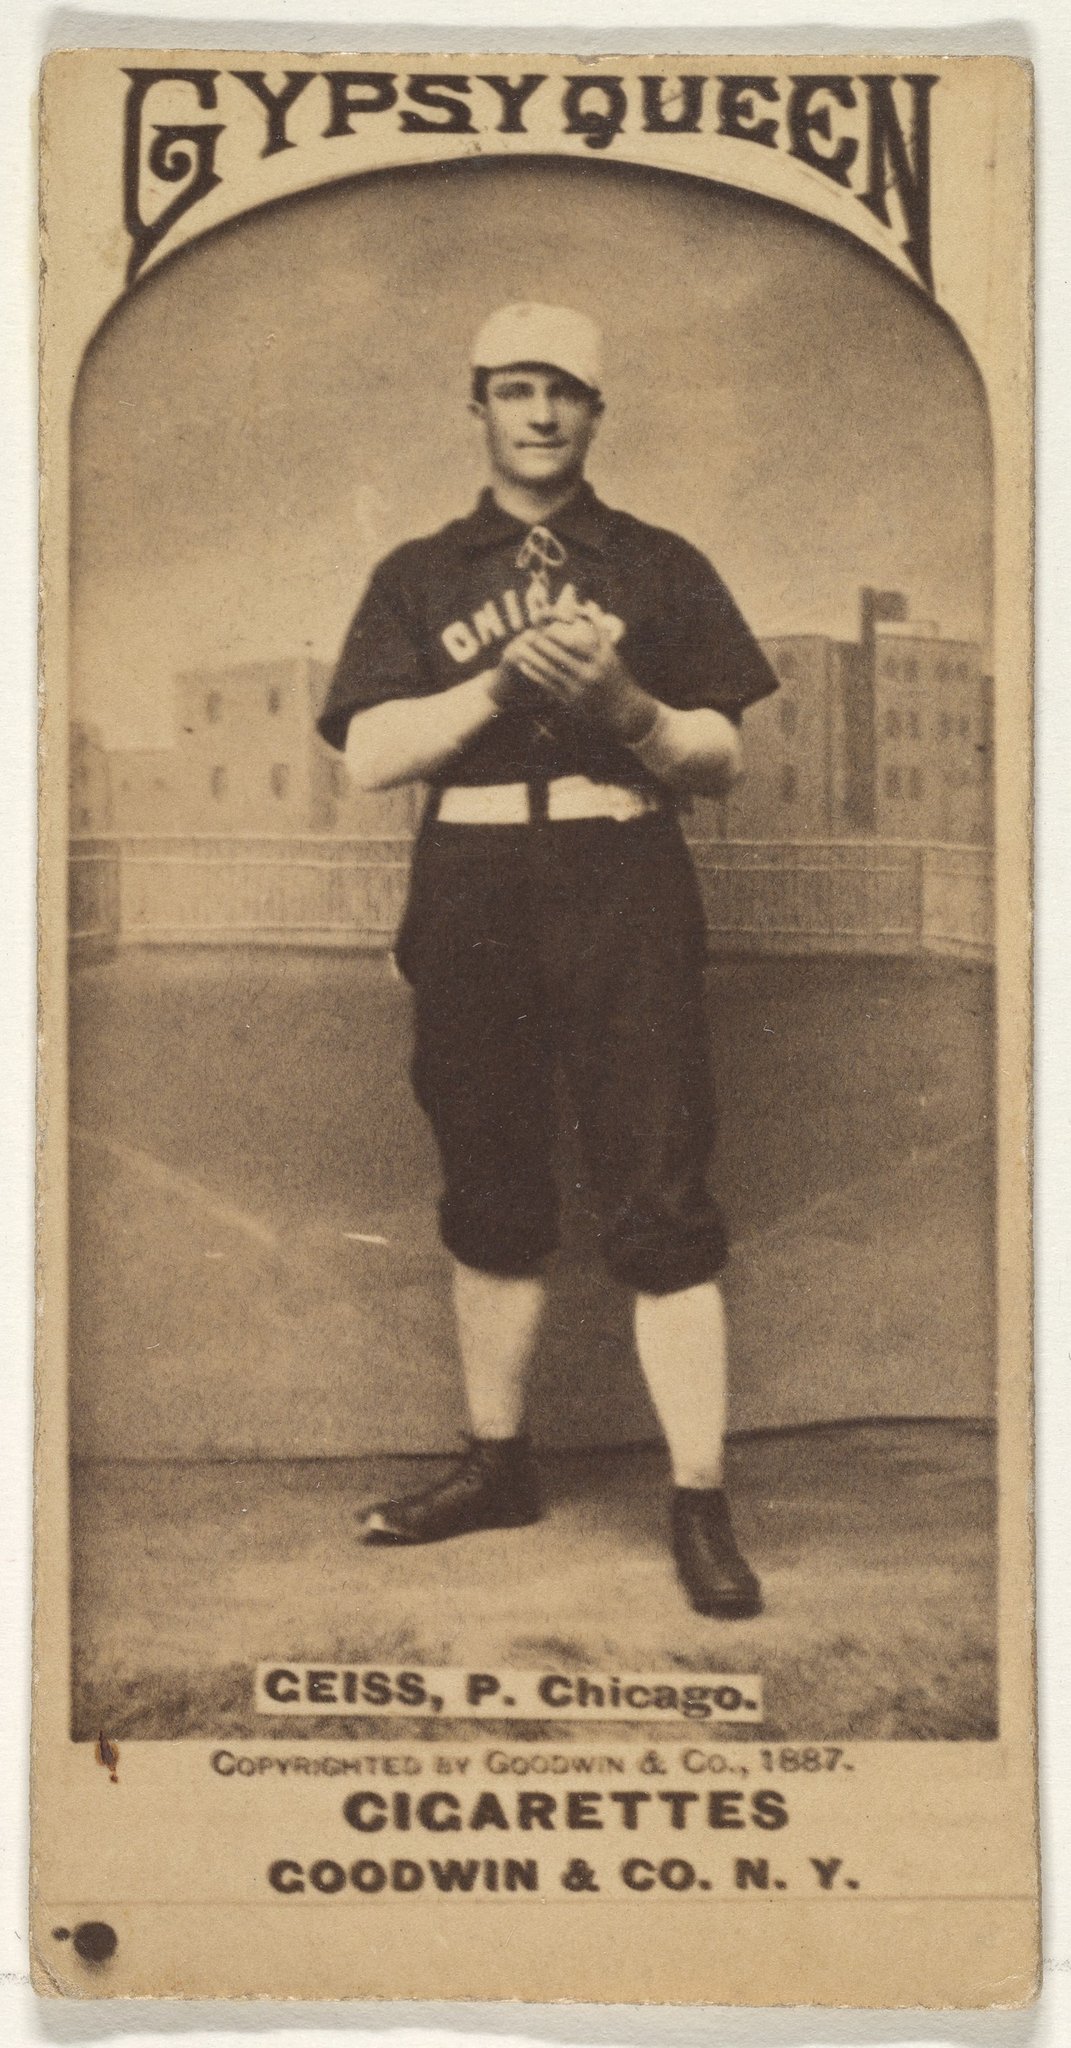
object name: baseball card, photograph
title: Ceiss, Pitcher, Chicago, from the Old Judge series (N172) for Old Judge and Gypsy Queen Cigarettes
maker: goodwin & company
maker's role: publisher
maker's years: 1850-1950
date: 1887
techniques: albumen silver print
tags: men,portraits,baseball,athletes